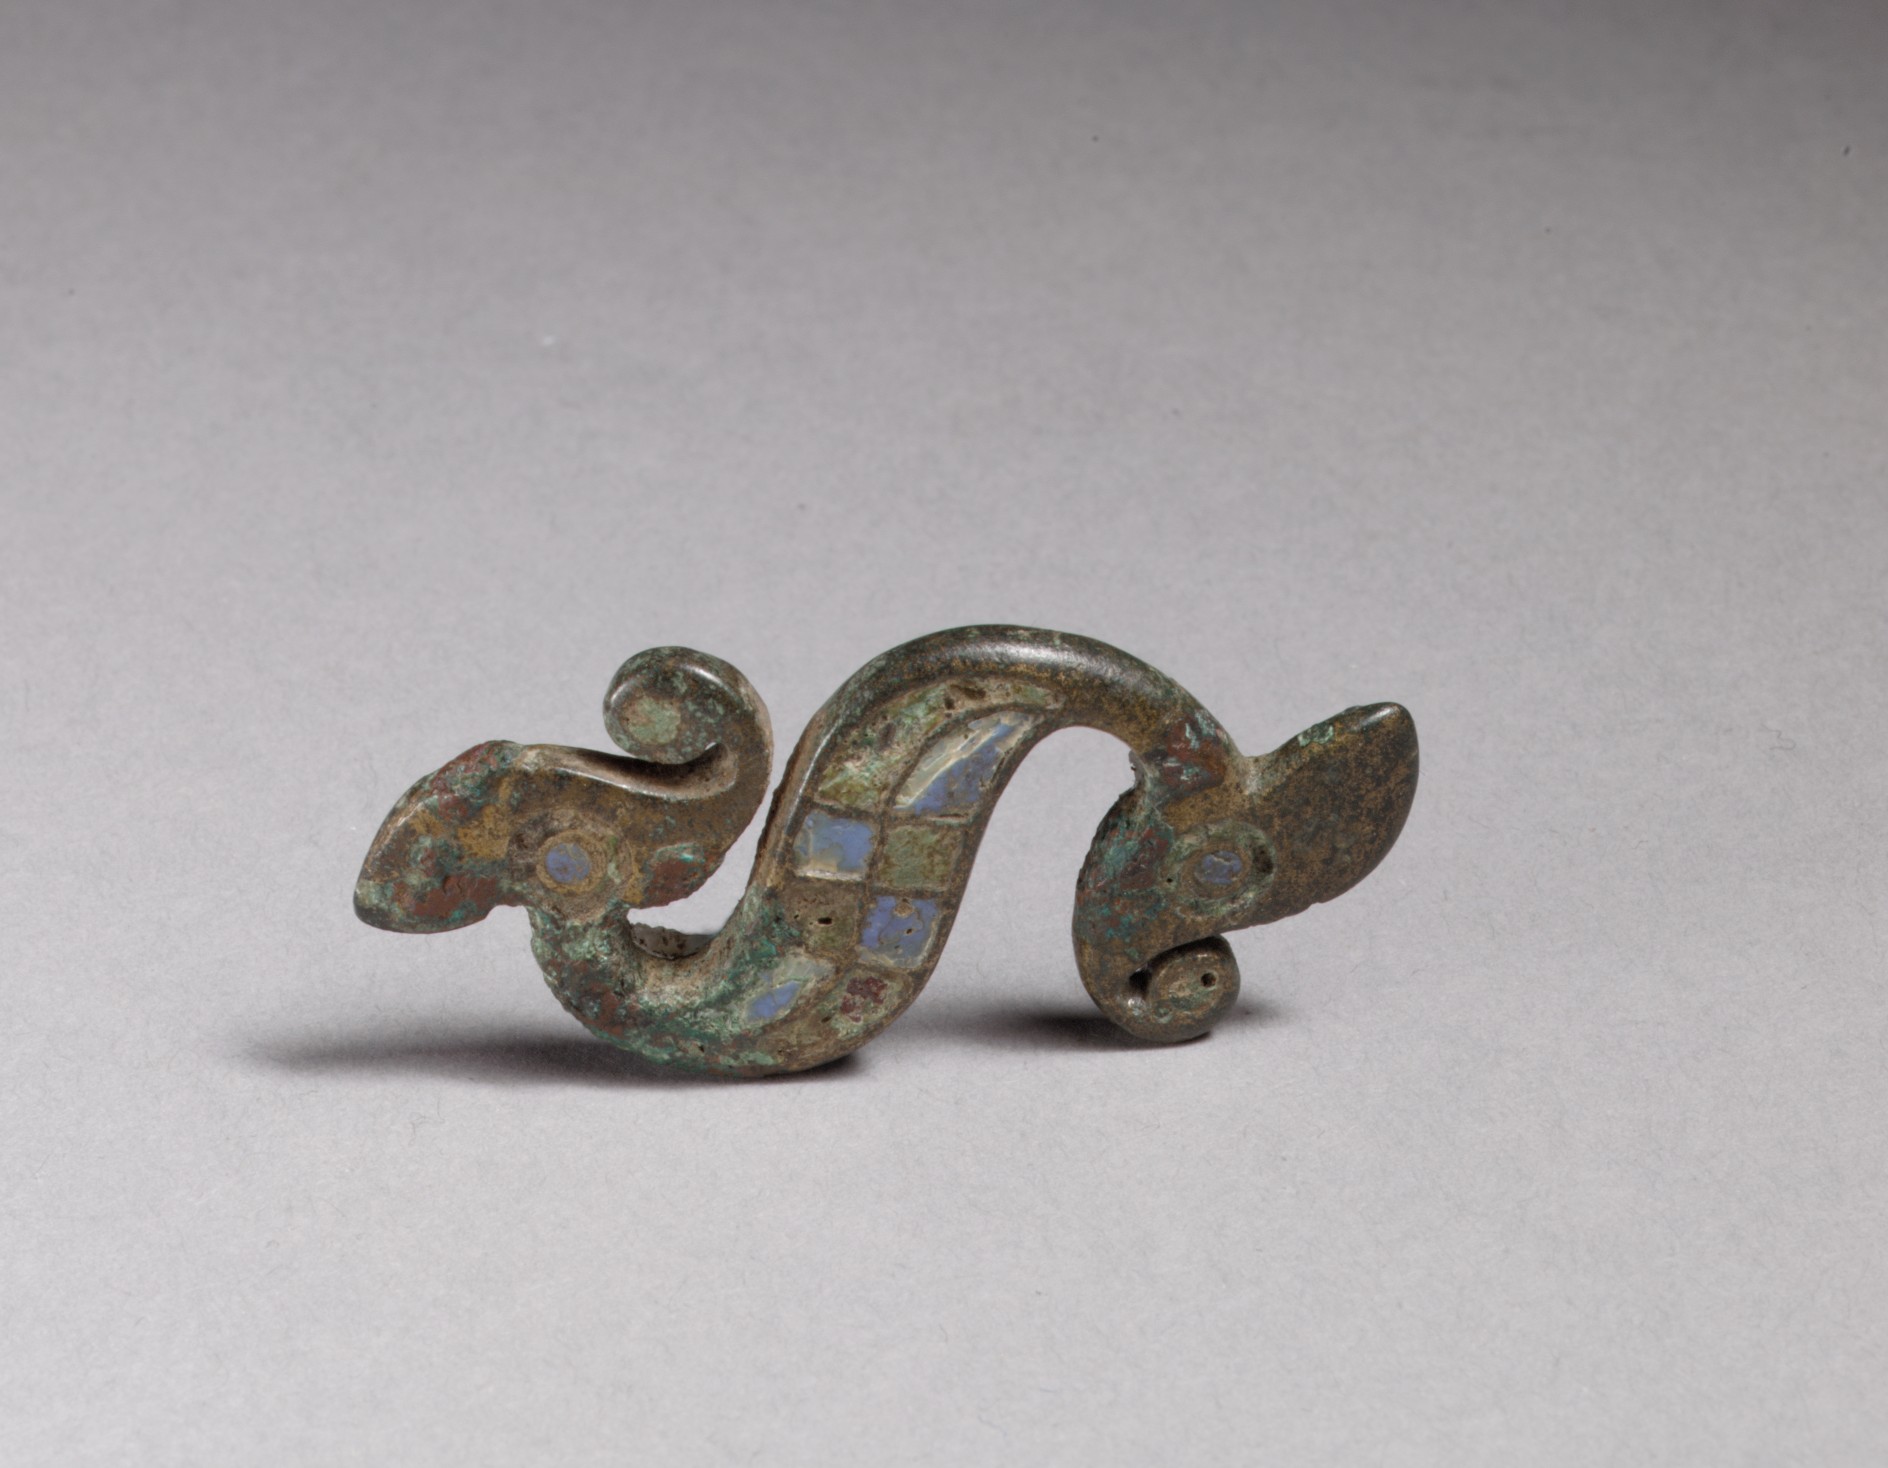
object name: brooch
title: Dragon-Shaped Brooch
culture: celtic or roman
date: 100-300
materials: copper alloy, enamel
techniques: enamel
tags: dragons